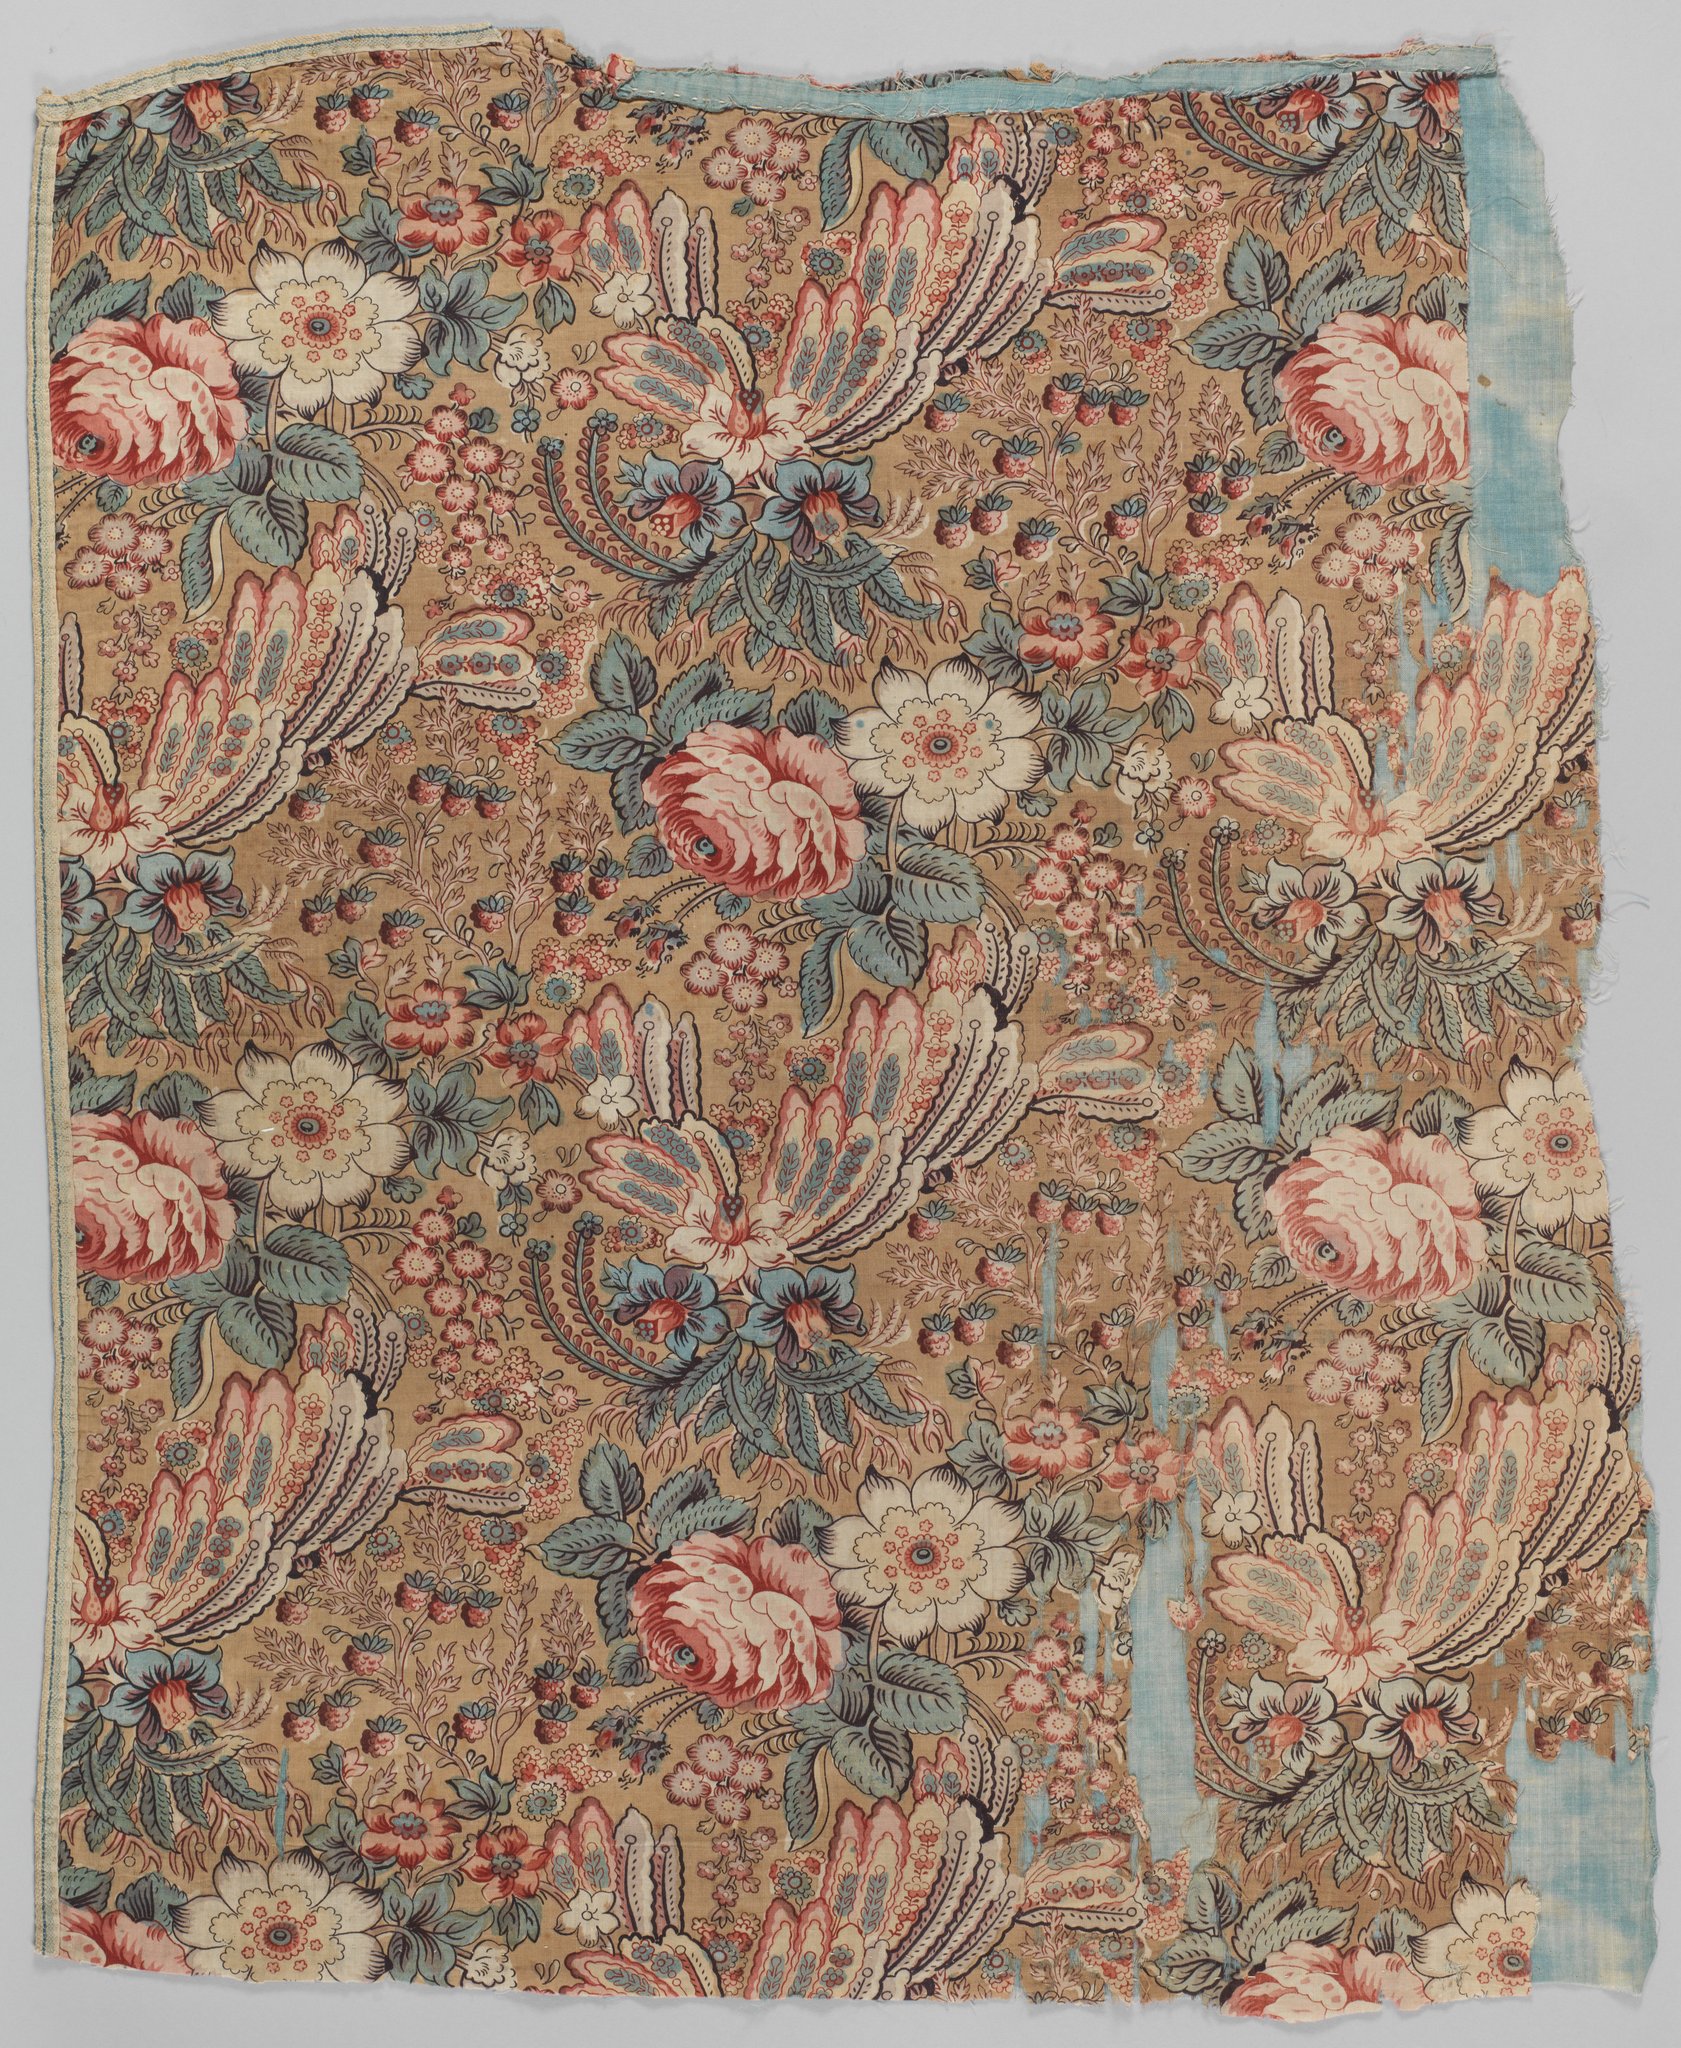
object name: piece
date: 1815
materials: cotton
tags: flowers,roses